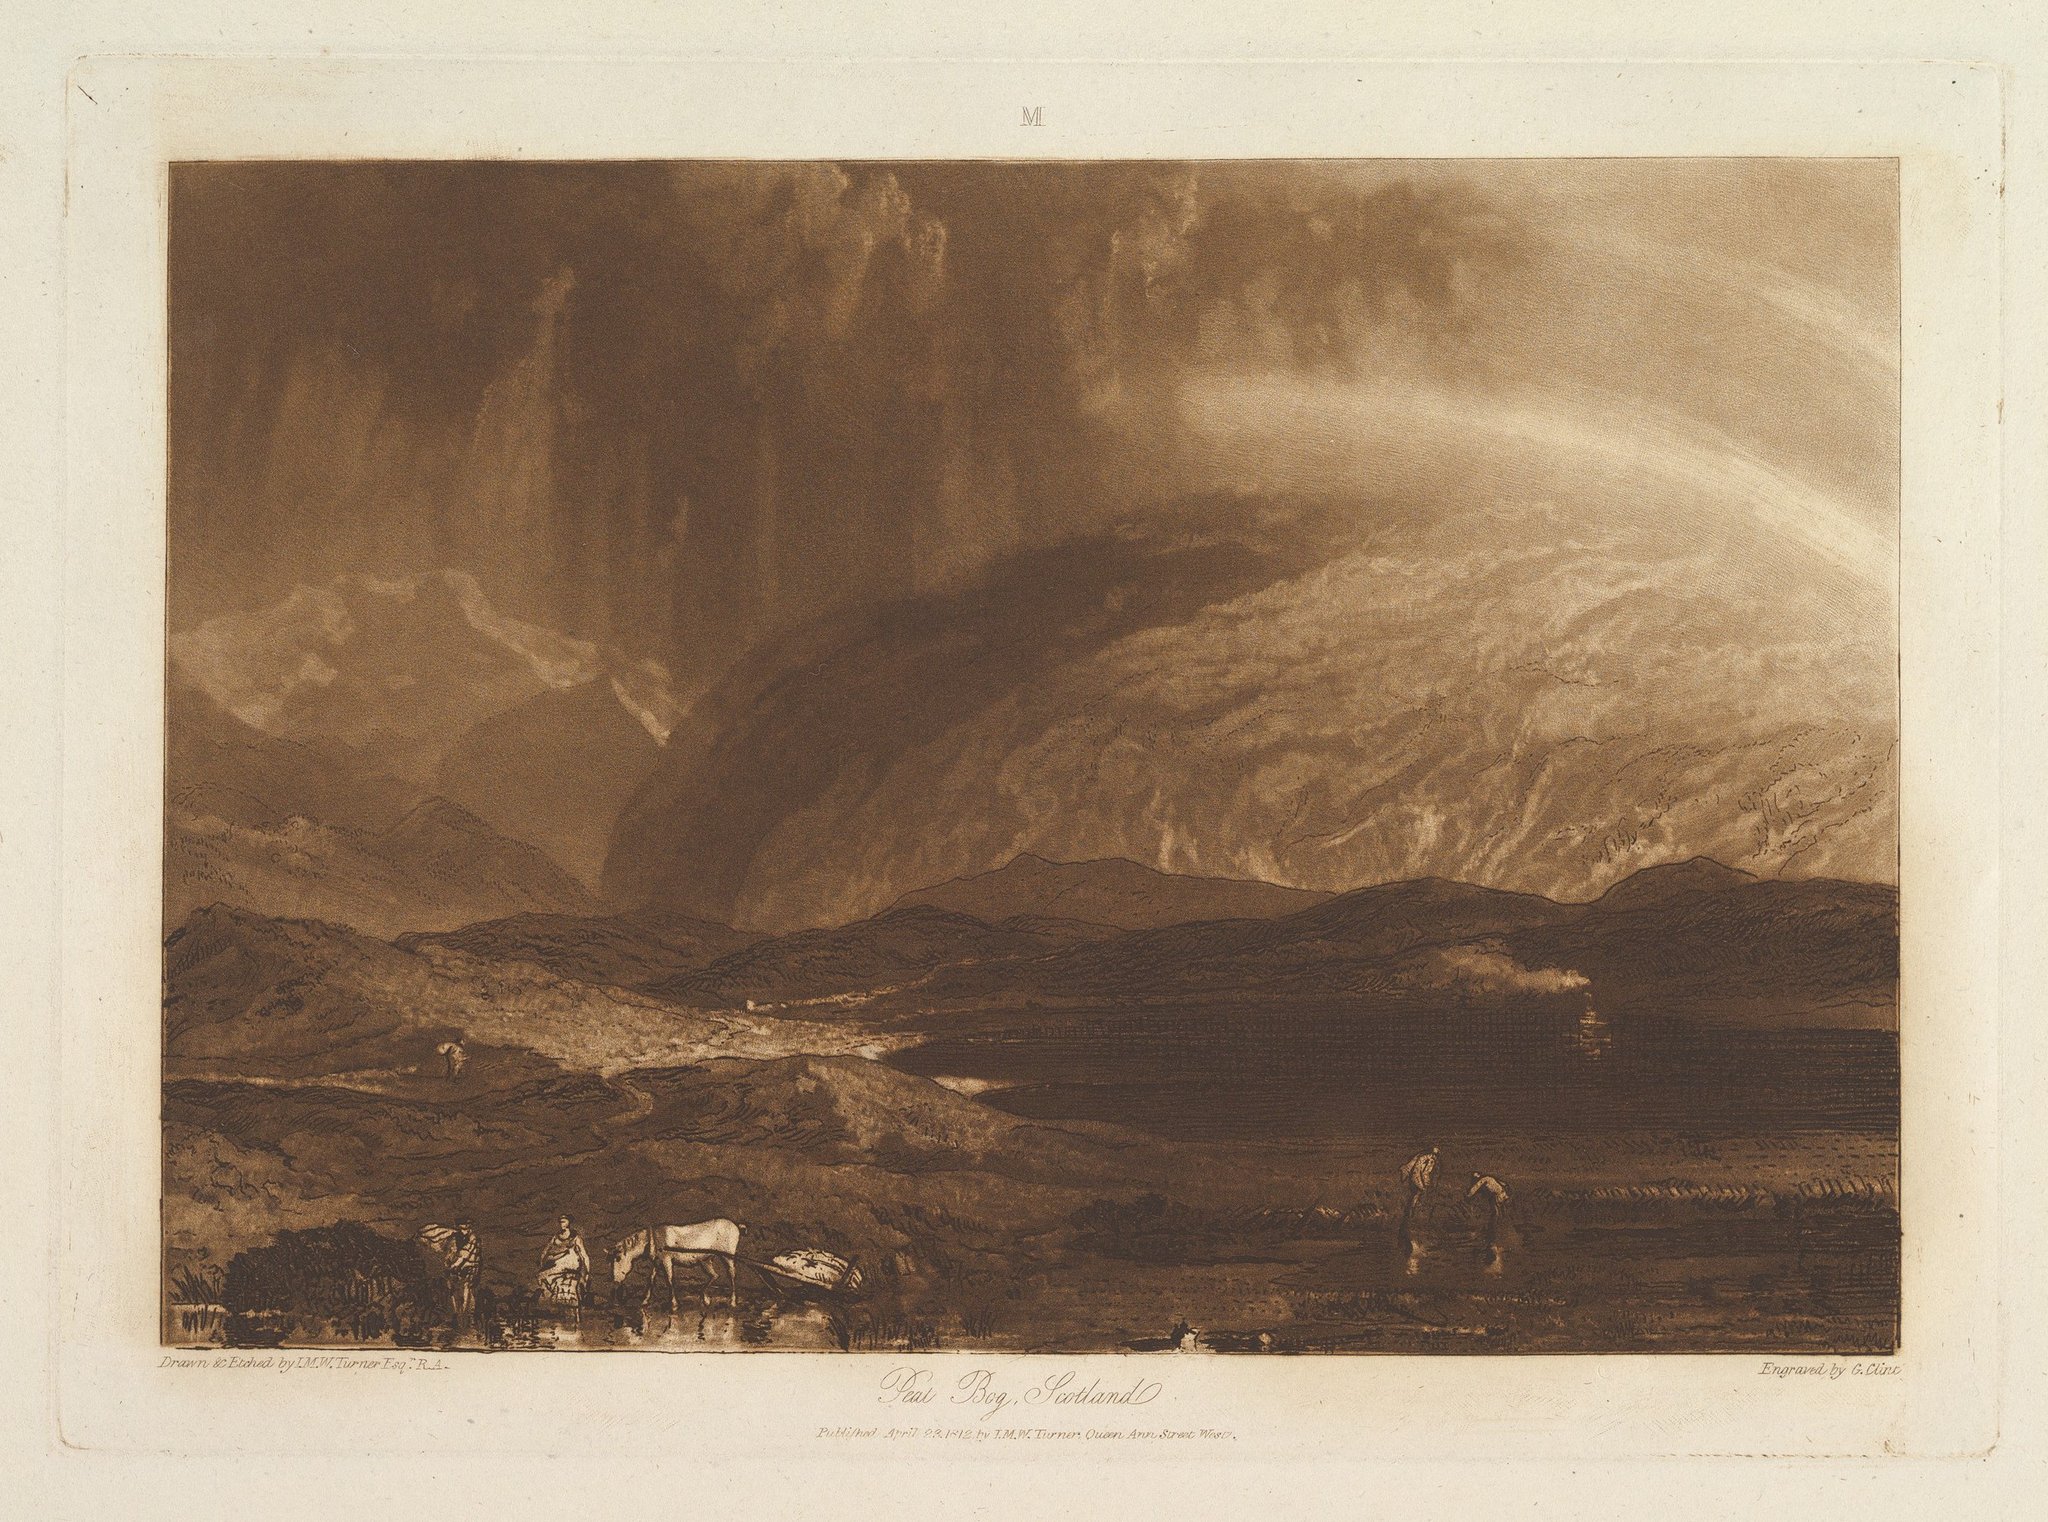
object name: print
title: Peat Bog, Scotland, part IX, plate 45 from "Liber Studiorum"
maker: joseph mallord william turner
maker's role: artist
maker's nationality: british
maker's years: 1775-1851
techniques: aquatint, etching, mezzotint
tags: horses,landscapes